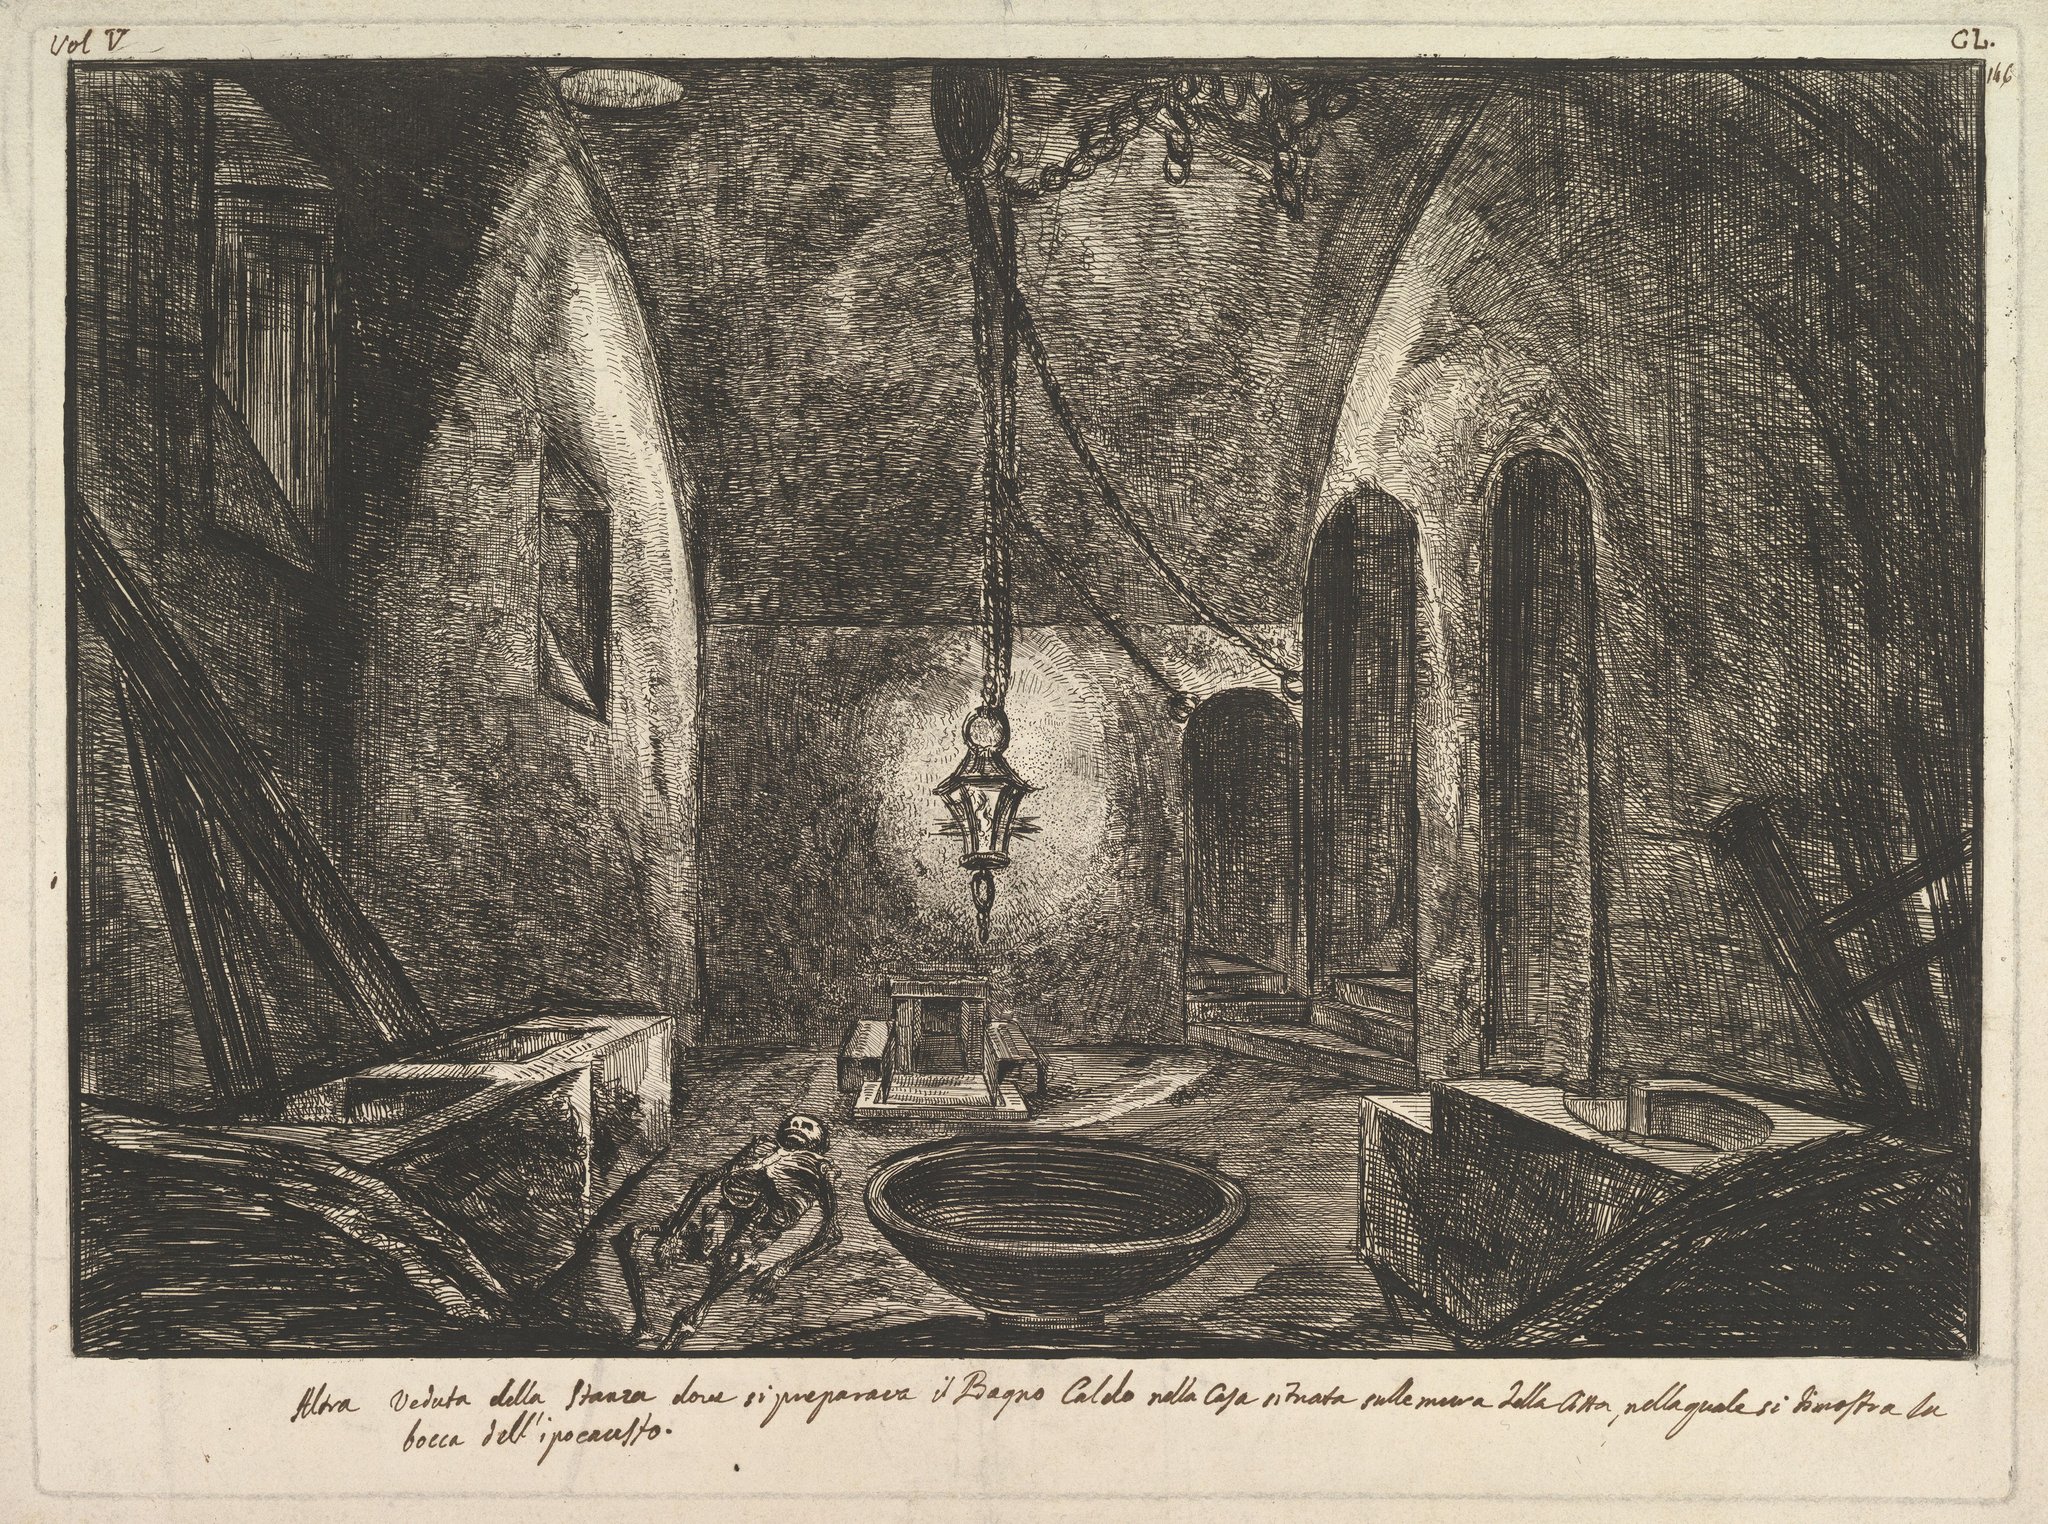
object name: print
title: View of Pompeii (Altra veduta della Stanza dove si preparava il Bogno Caldo . . . )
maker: francesco piranesi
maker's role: artist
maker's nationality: italian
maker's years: 1758-1810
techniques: etching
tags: interiors,skeletons,lamps